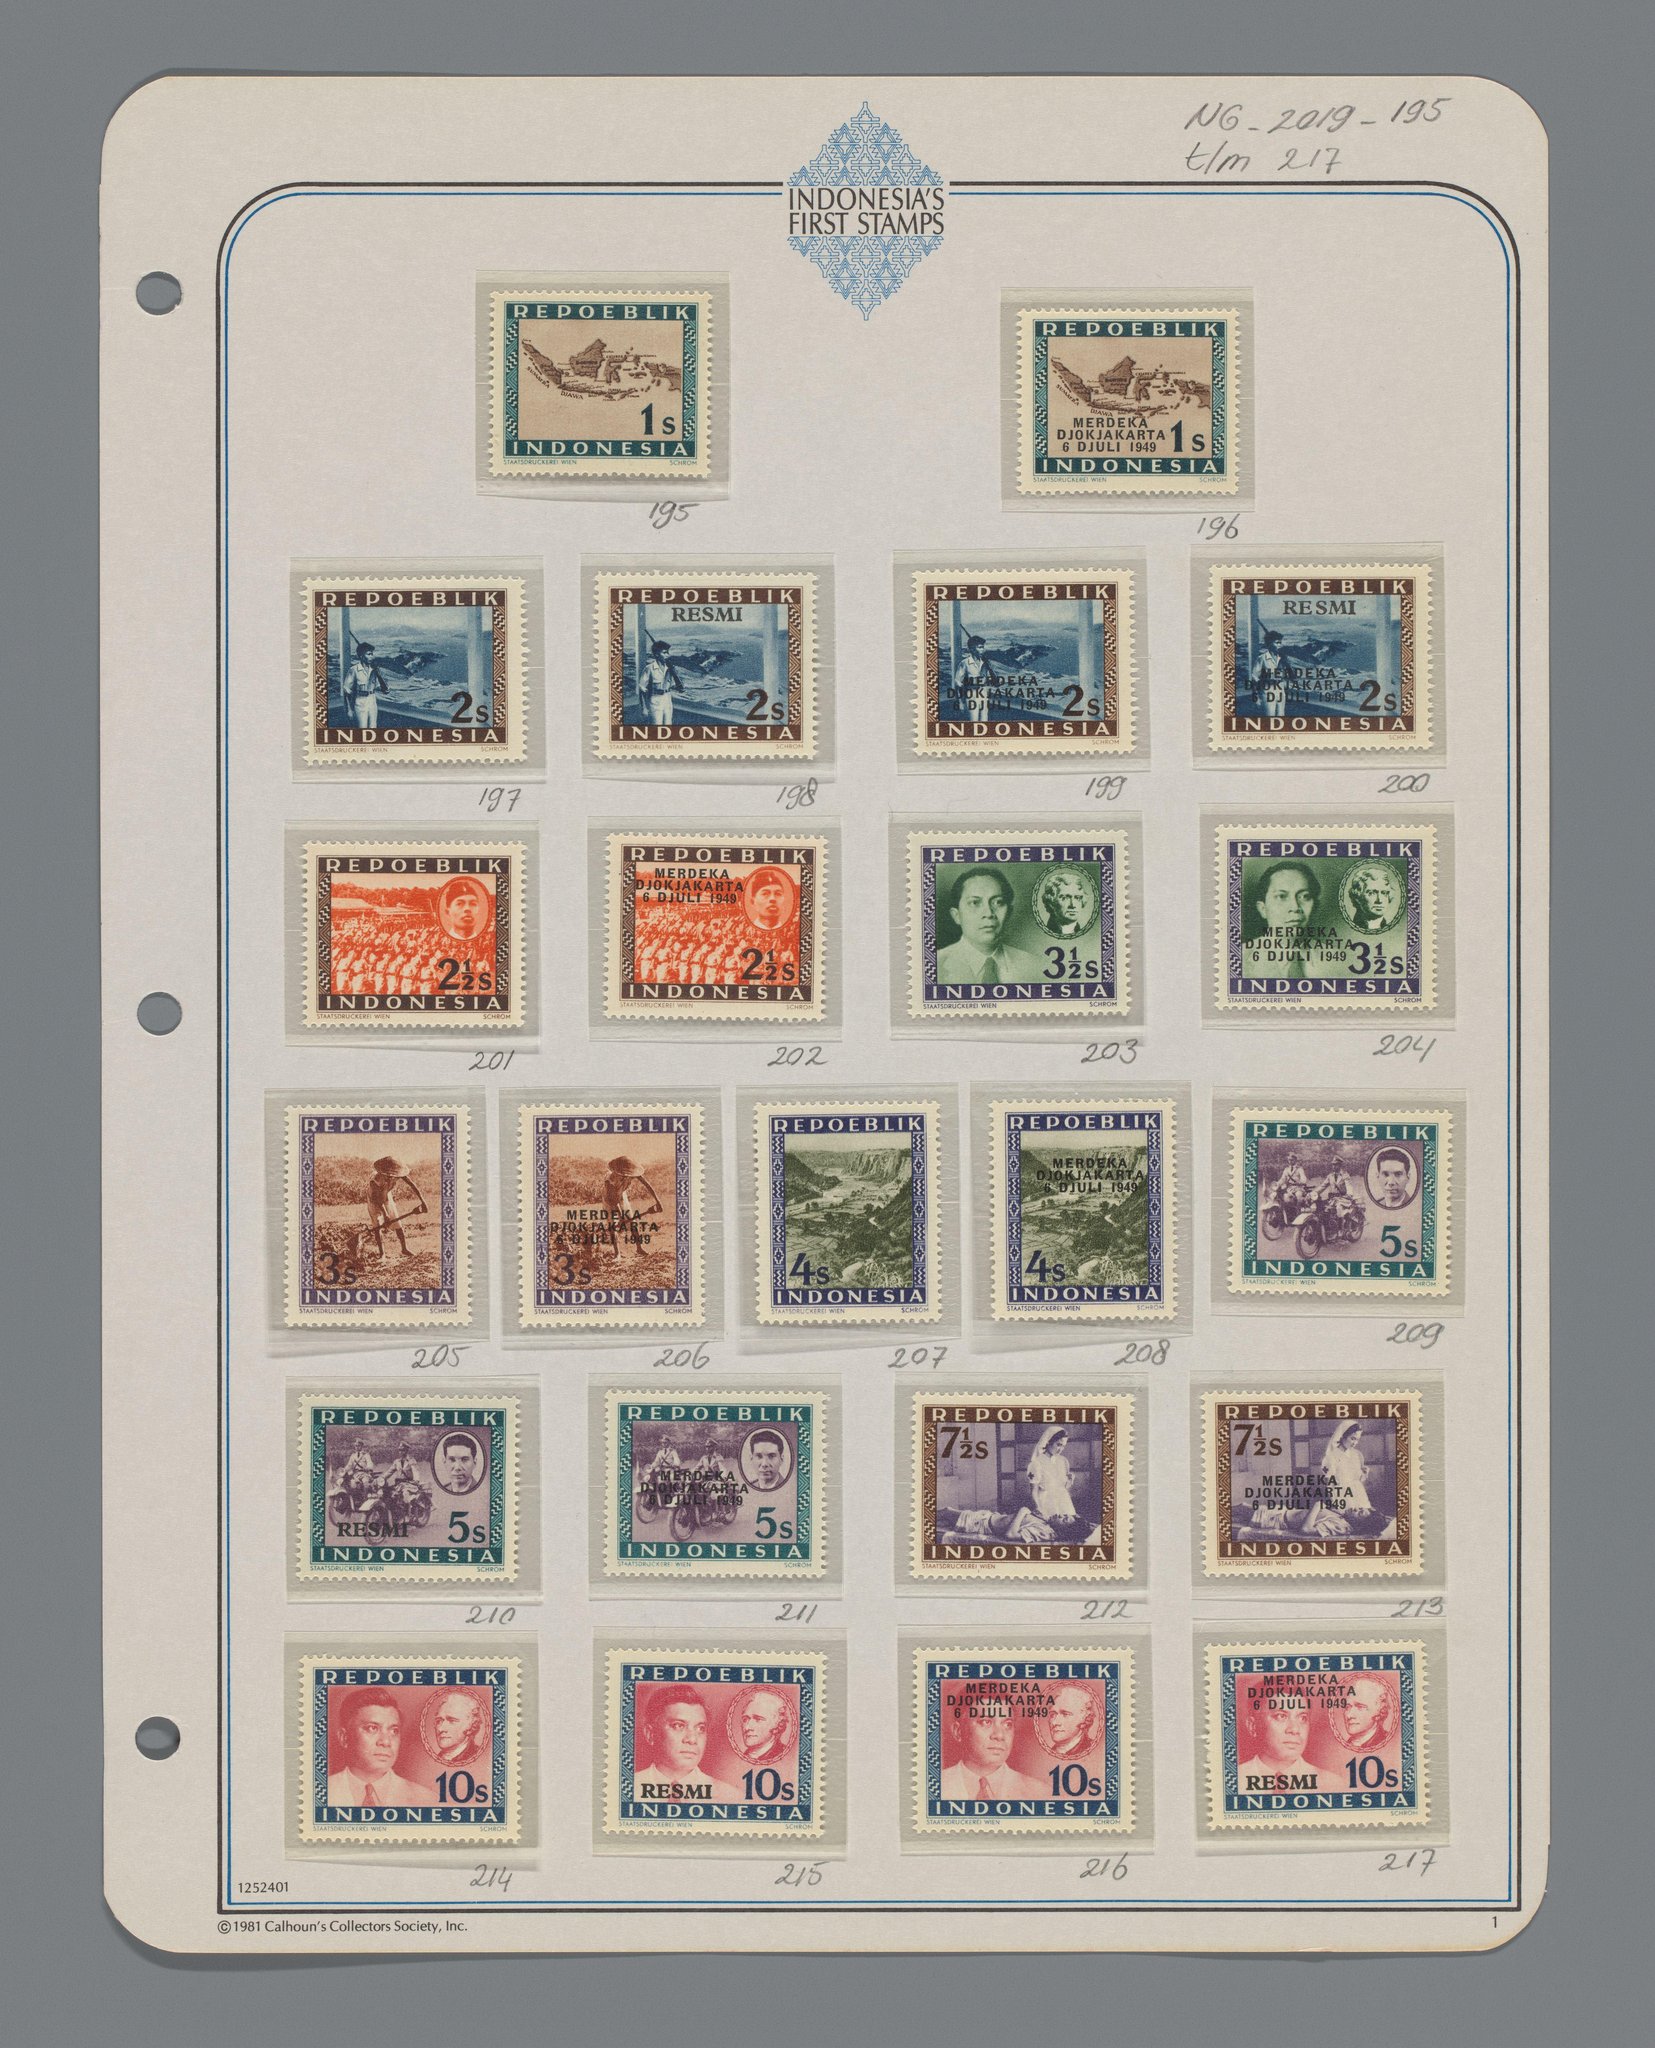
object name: postage stamp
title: Postzegel Republik Indonesia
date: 1949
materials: paper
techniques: photoaquatint, engraving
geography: philadelphia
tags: indonesia